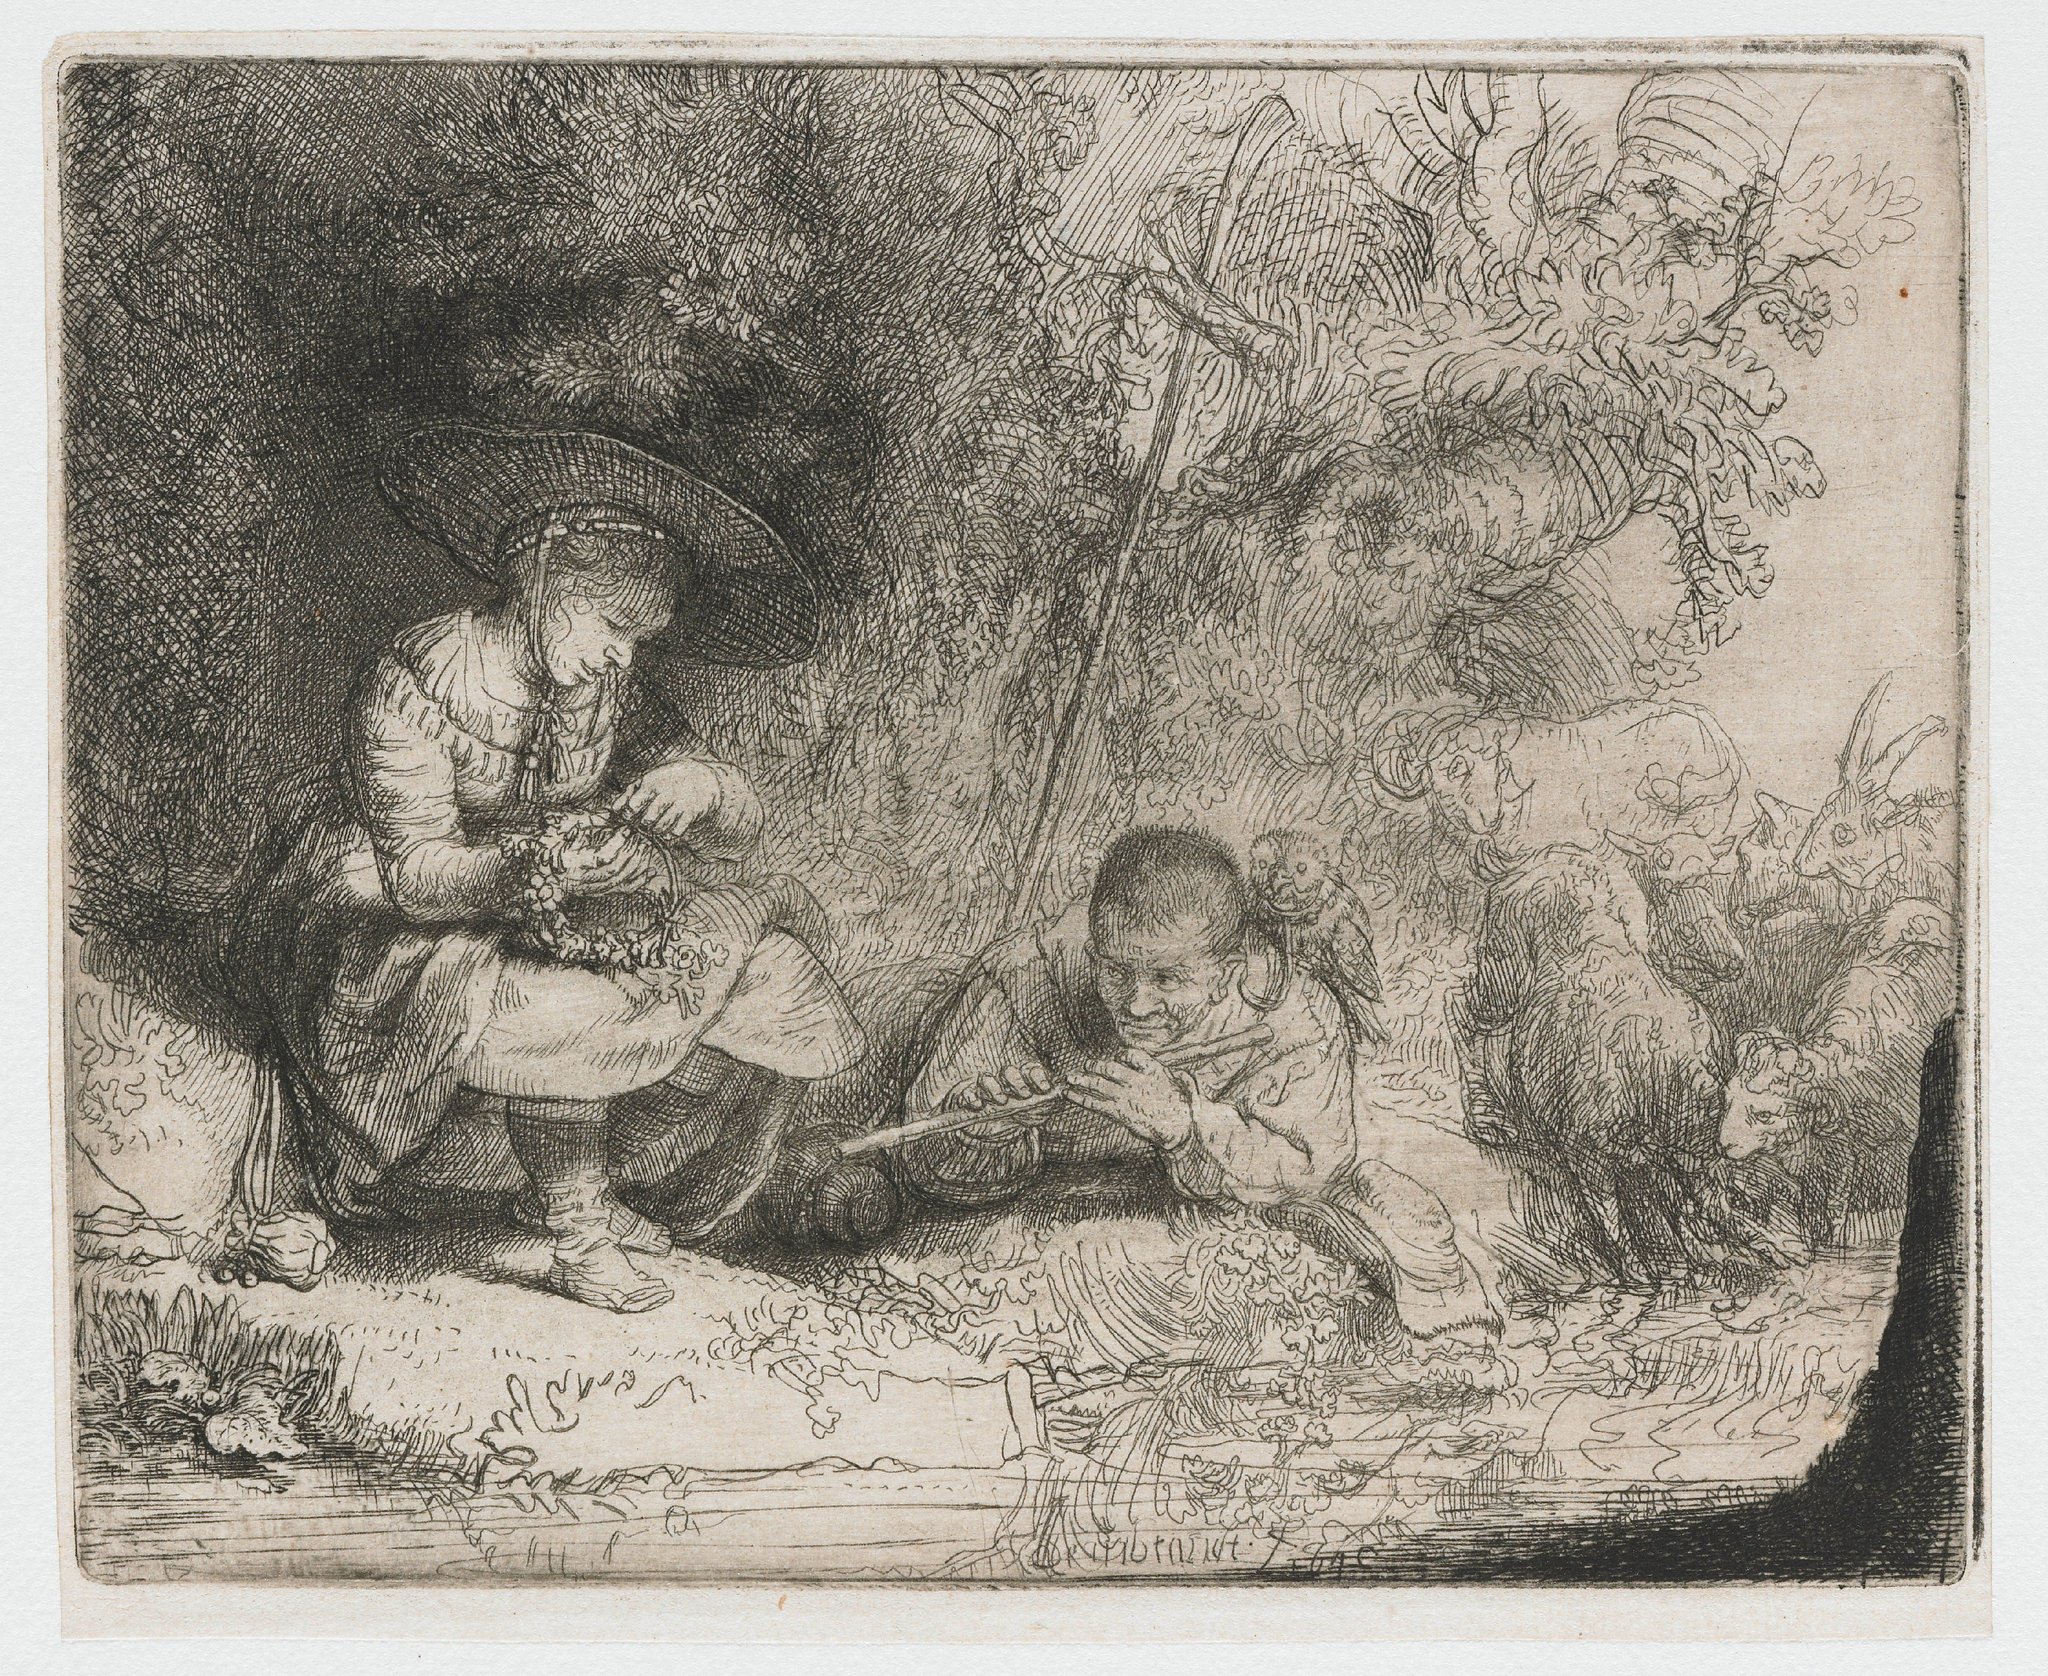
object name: print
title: The flute player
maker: rembrandt van rijn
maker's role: draughtsman, painter, print maker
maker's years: 1606-1669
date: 1642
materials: paper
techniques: drypoint, etching, intaglio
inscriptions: collector's mark: Lugt 240, signature and date: ‘Rembrandt f. 1642’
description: This print was formerly called ‘het Uylenspiegeltje’ (the scoundrel), and not without reason. Rembrandt concealed all kinds of erotic double entendres in this scene of a shepherd couple beside the water. The man furtively peeks under the woman’s skirt and happens to point with his flute – a phallic symbol – in the same direction. The woman is weaving a wreath of flowers, an allusion to female genitalia.